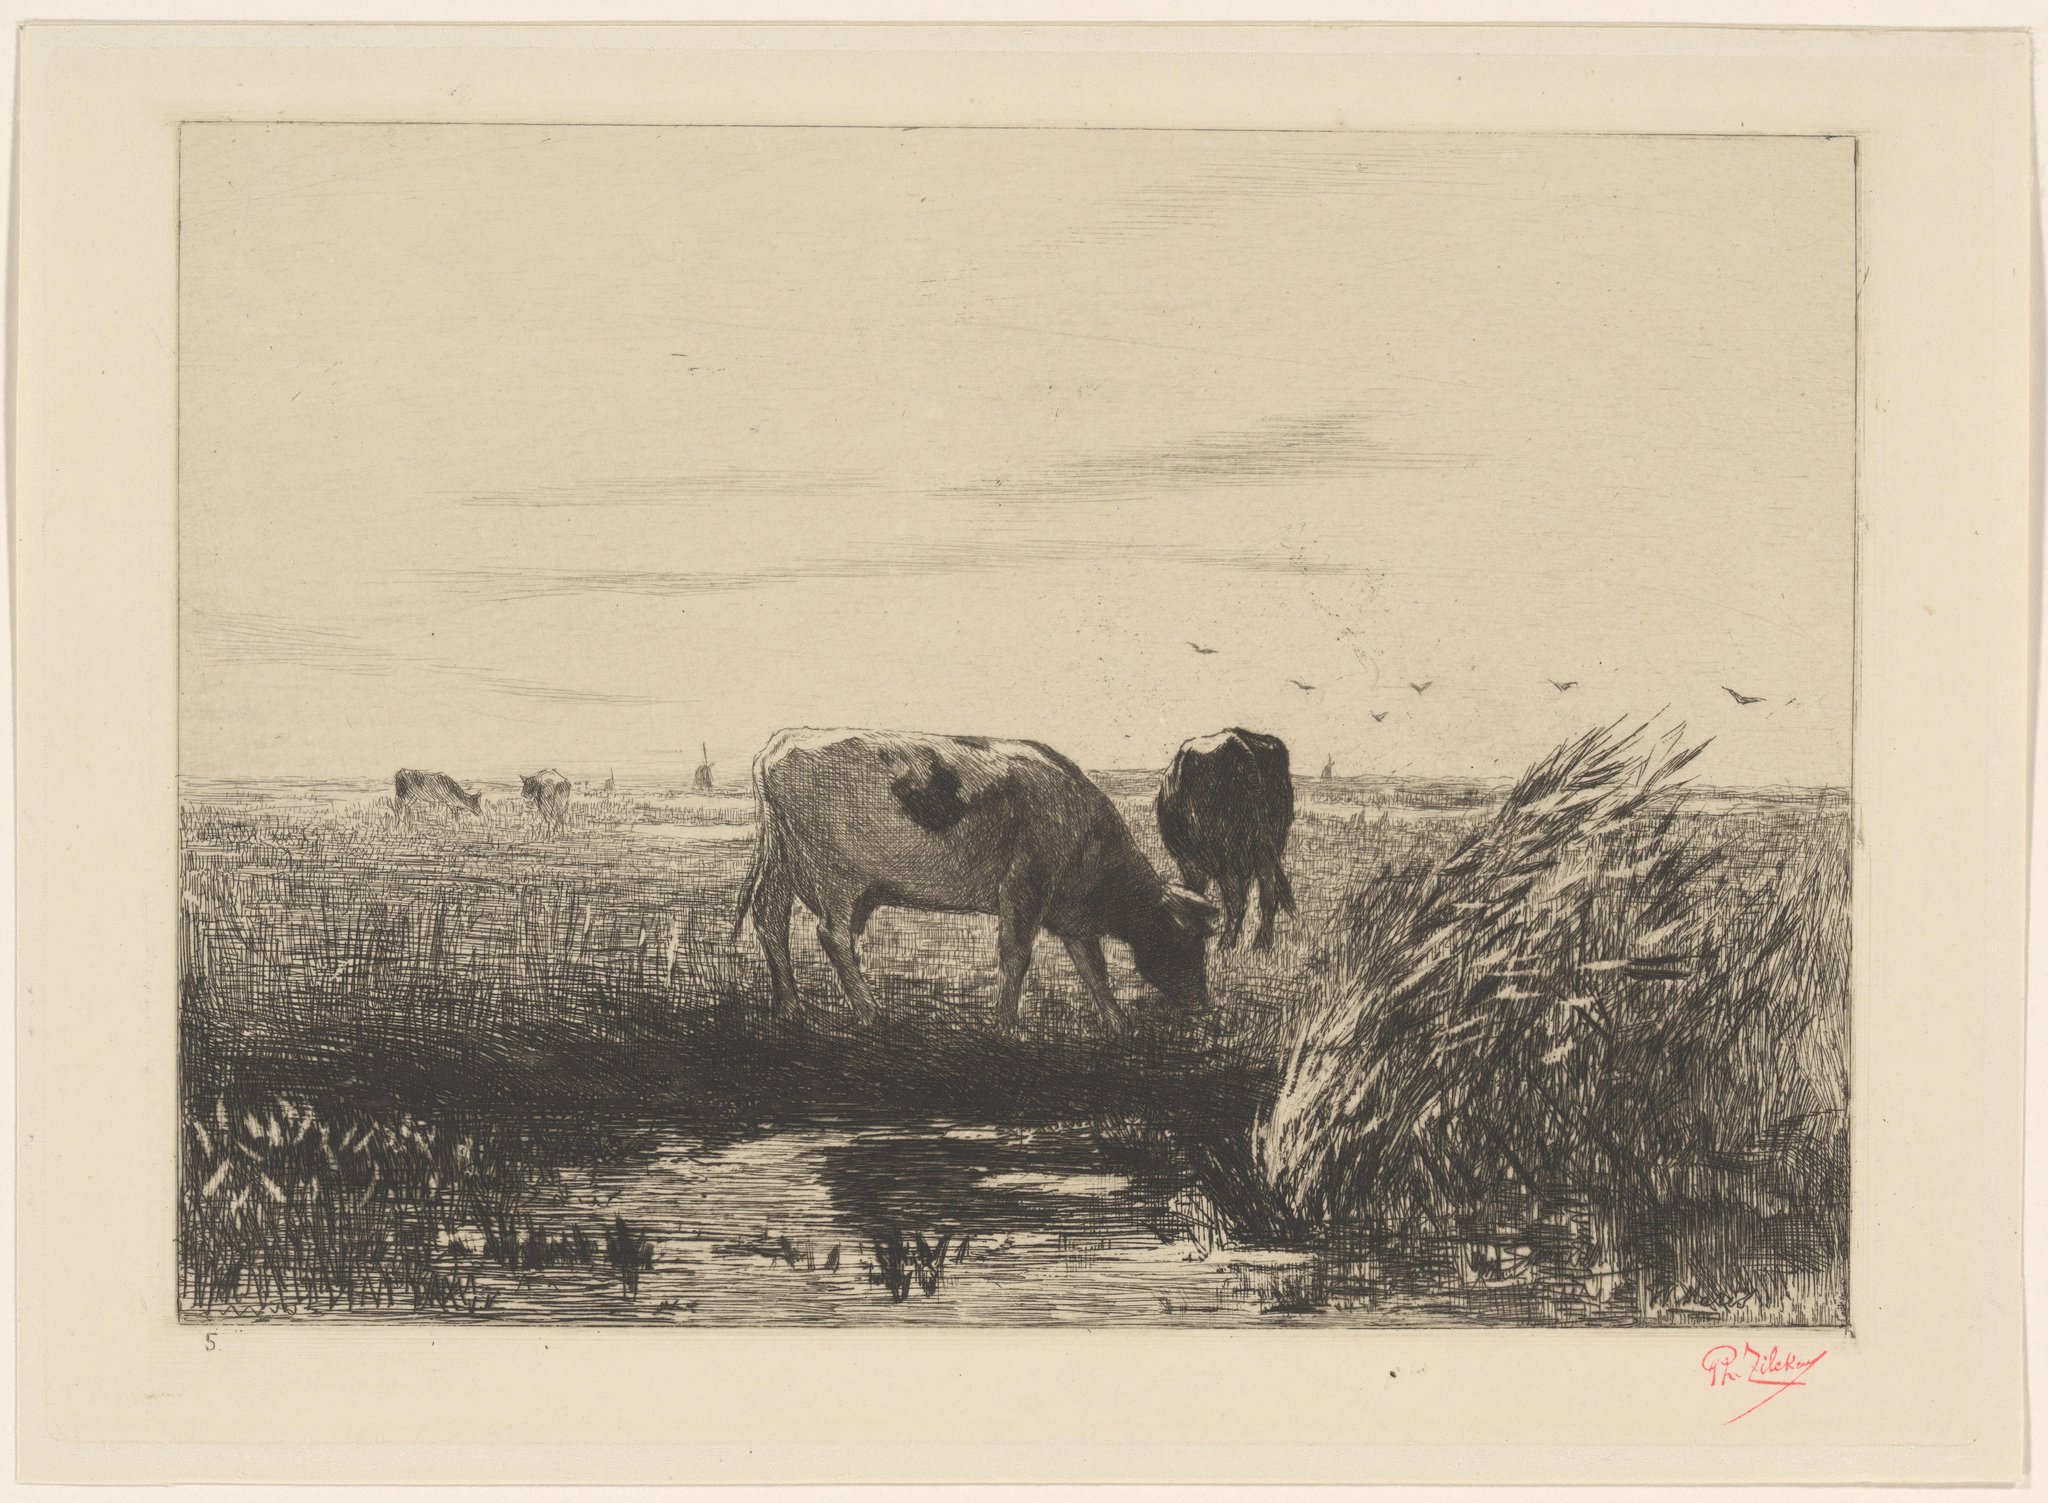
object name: print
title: Grazende koeien in een weide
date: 1867-1890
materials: paper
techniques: drypoint, etching, intaglio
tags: cow, meadow, pasture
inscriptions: collector's mark: Lugt 2228